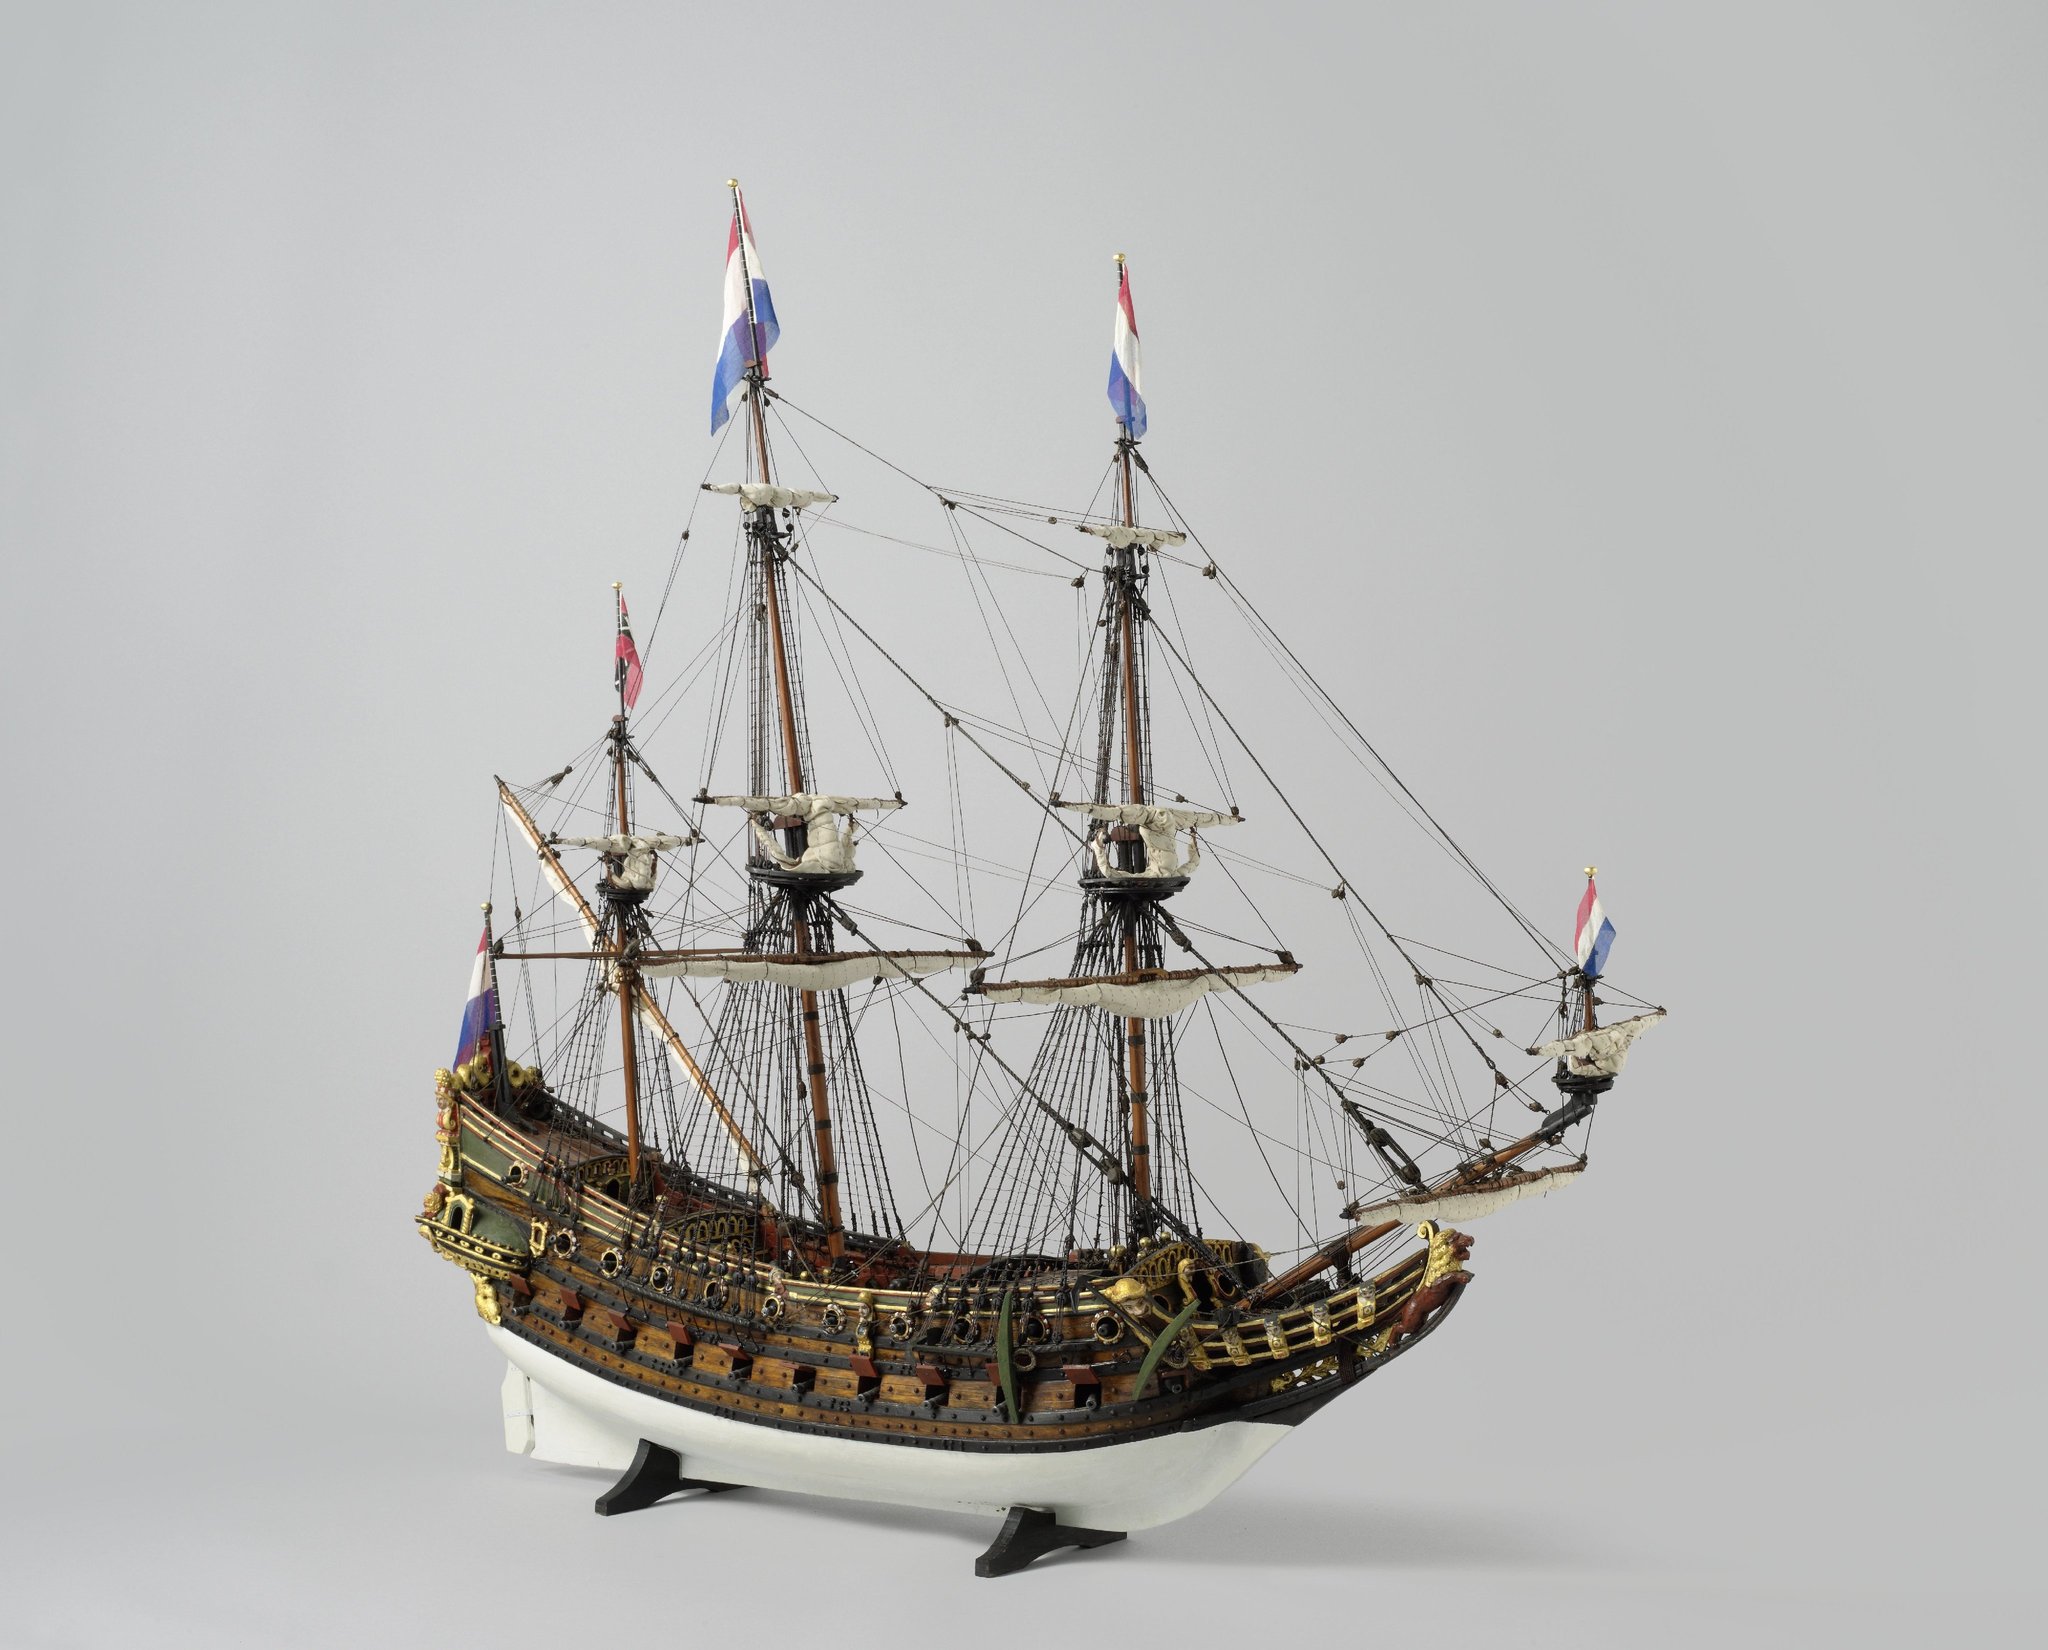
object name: show model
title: Model of a 44-Gun Dutch Warship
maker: Anonymous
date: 1648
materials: lead, fiber, textile, wood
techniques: polychromy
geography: netherlands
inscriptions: inscription: ‘anno 1648’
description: Dutch warships were relatively small in the mid-17th century. This proved to be a problem, particularly during the First Anglo-Dutch War (1652–1654): they were no match for England’s larger, more heavily armed ships. An extensive and successful fleet-building programme was subsequently implemented. However, Dutch ships always remained smaller than those of other countries, largely due to the shallow waters around the Netherlands.